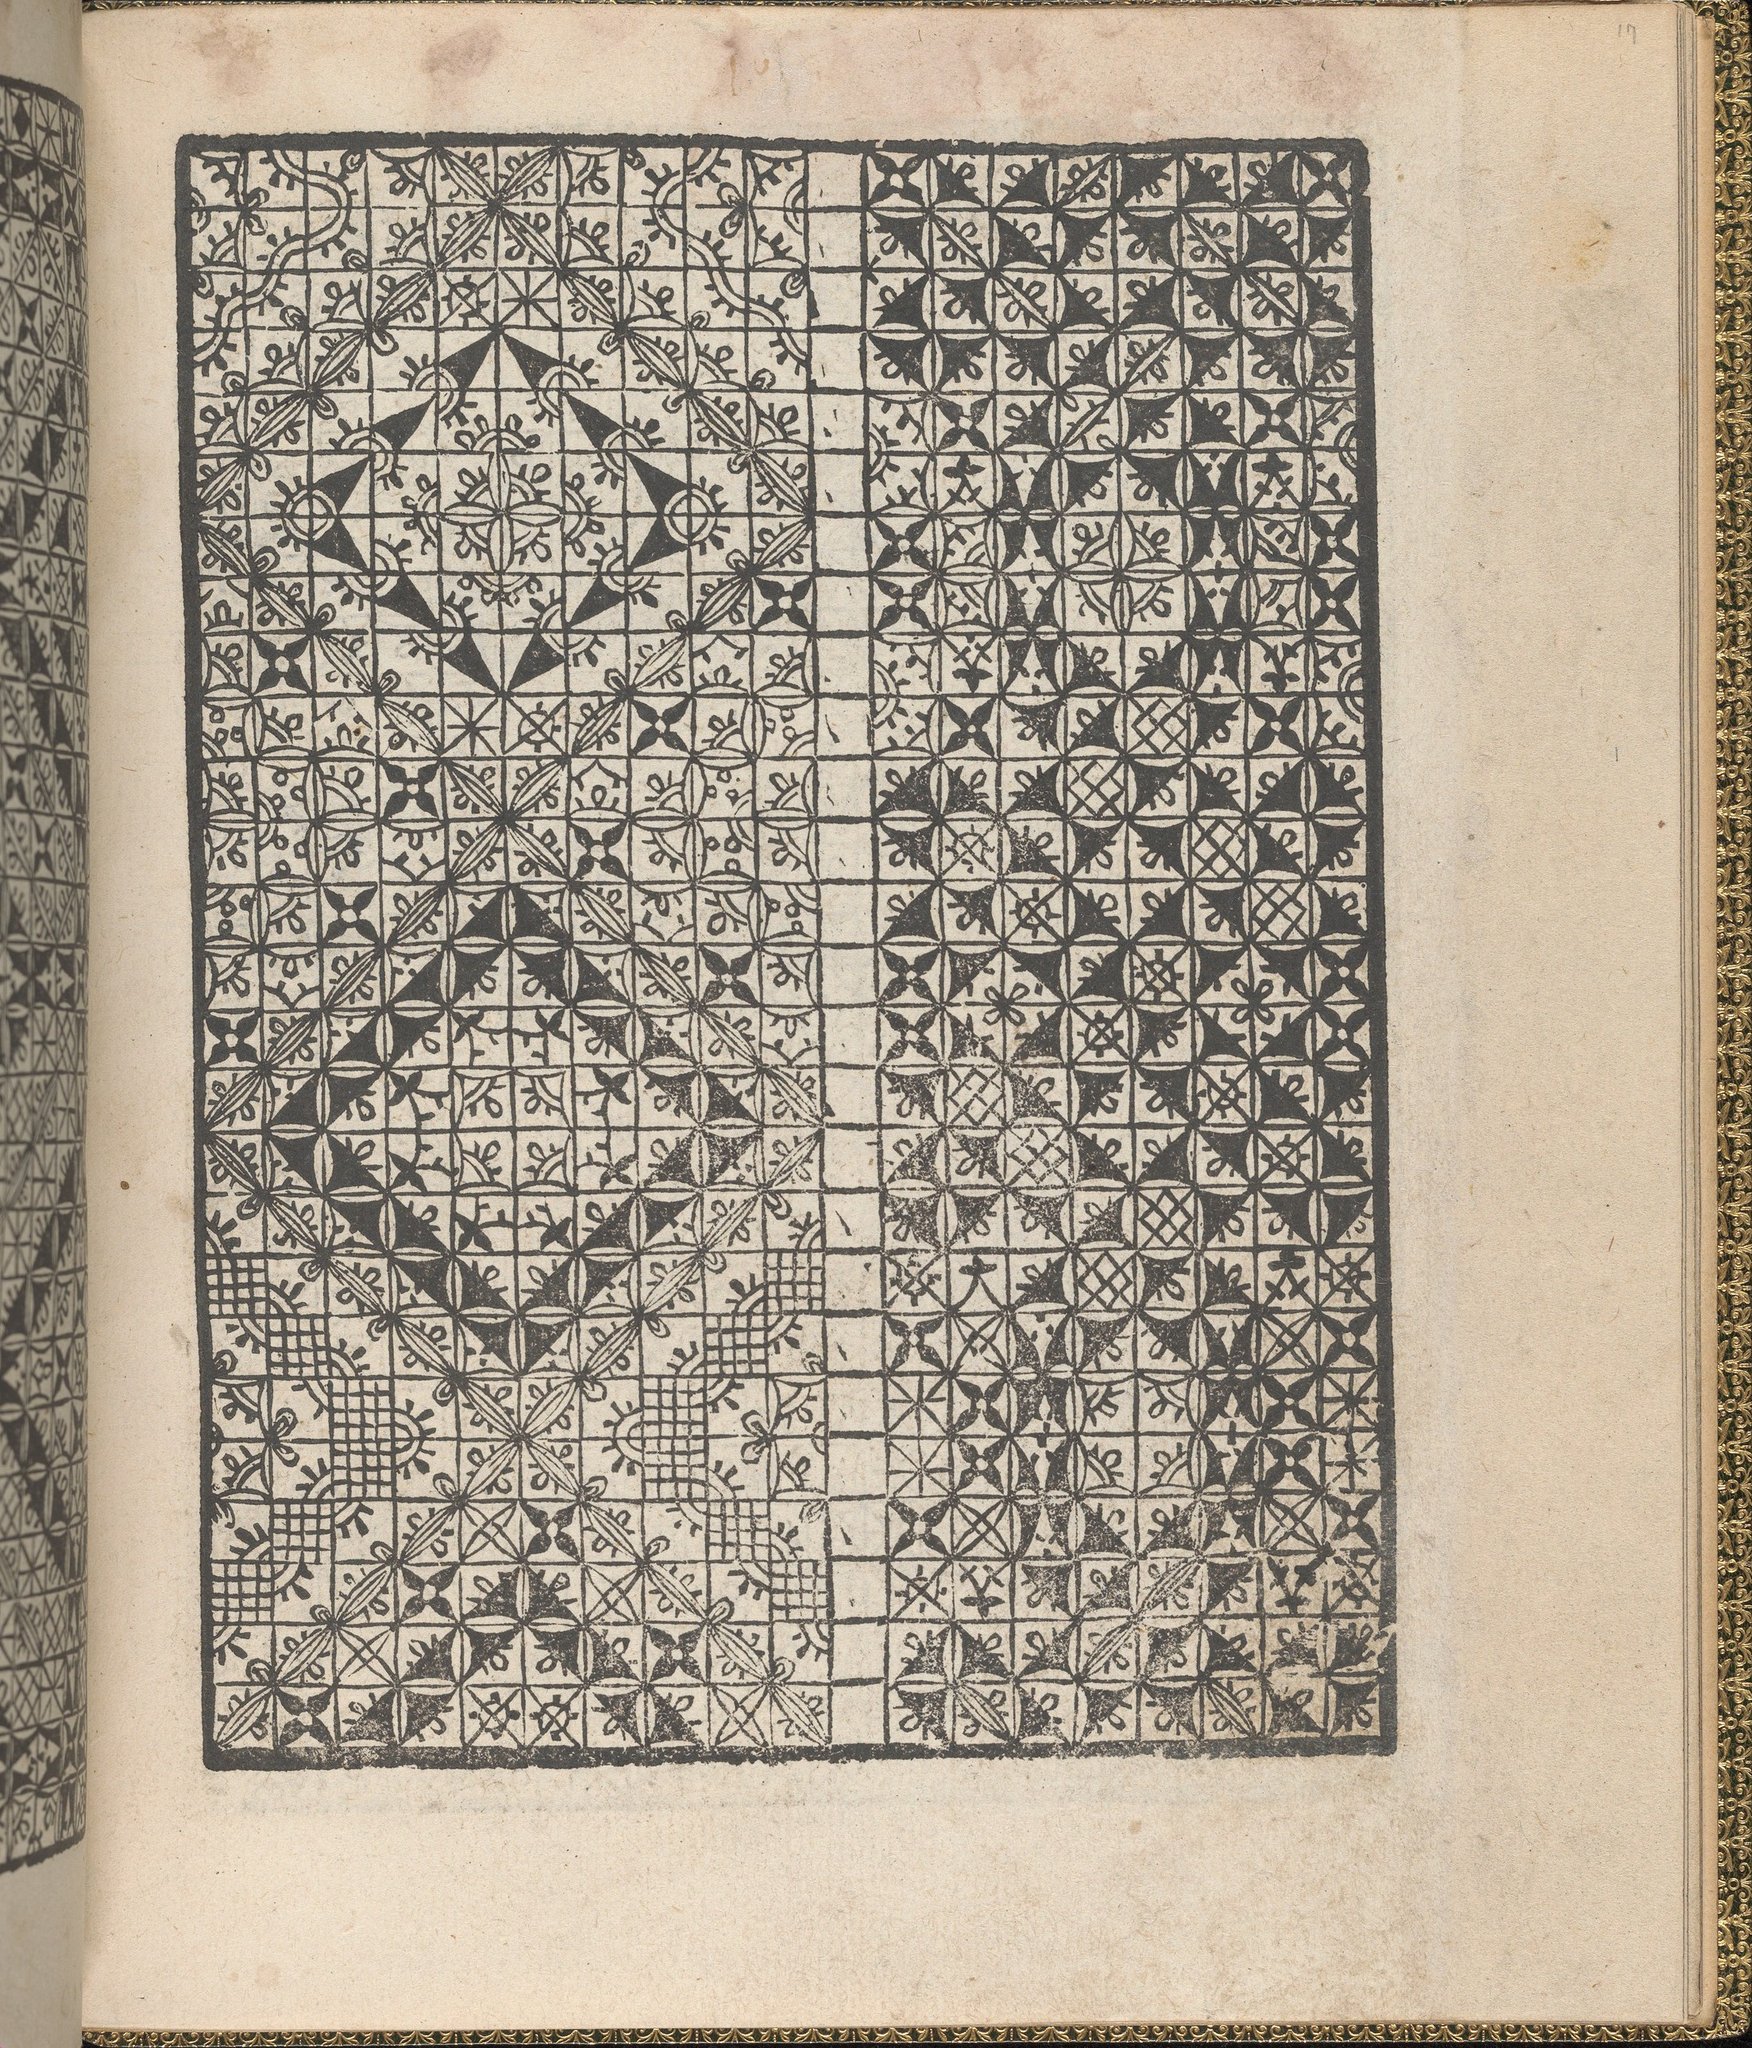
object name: book print ornament architecture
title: Giardineto novo di punti tagliati et gropposi per exercitio & ornamento delle donne (Venice 1554), page 17 (recto)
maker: matteo pagano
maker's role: publisher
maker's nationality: italian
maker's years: 1515-1588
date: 1554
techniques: woodcut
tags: ornament